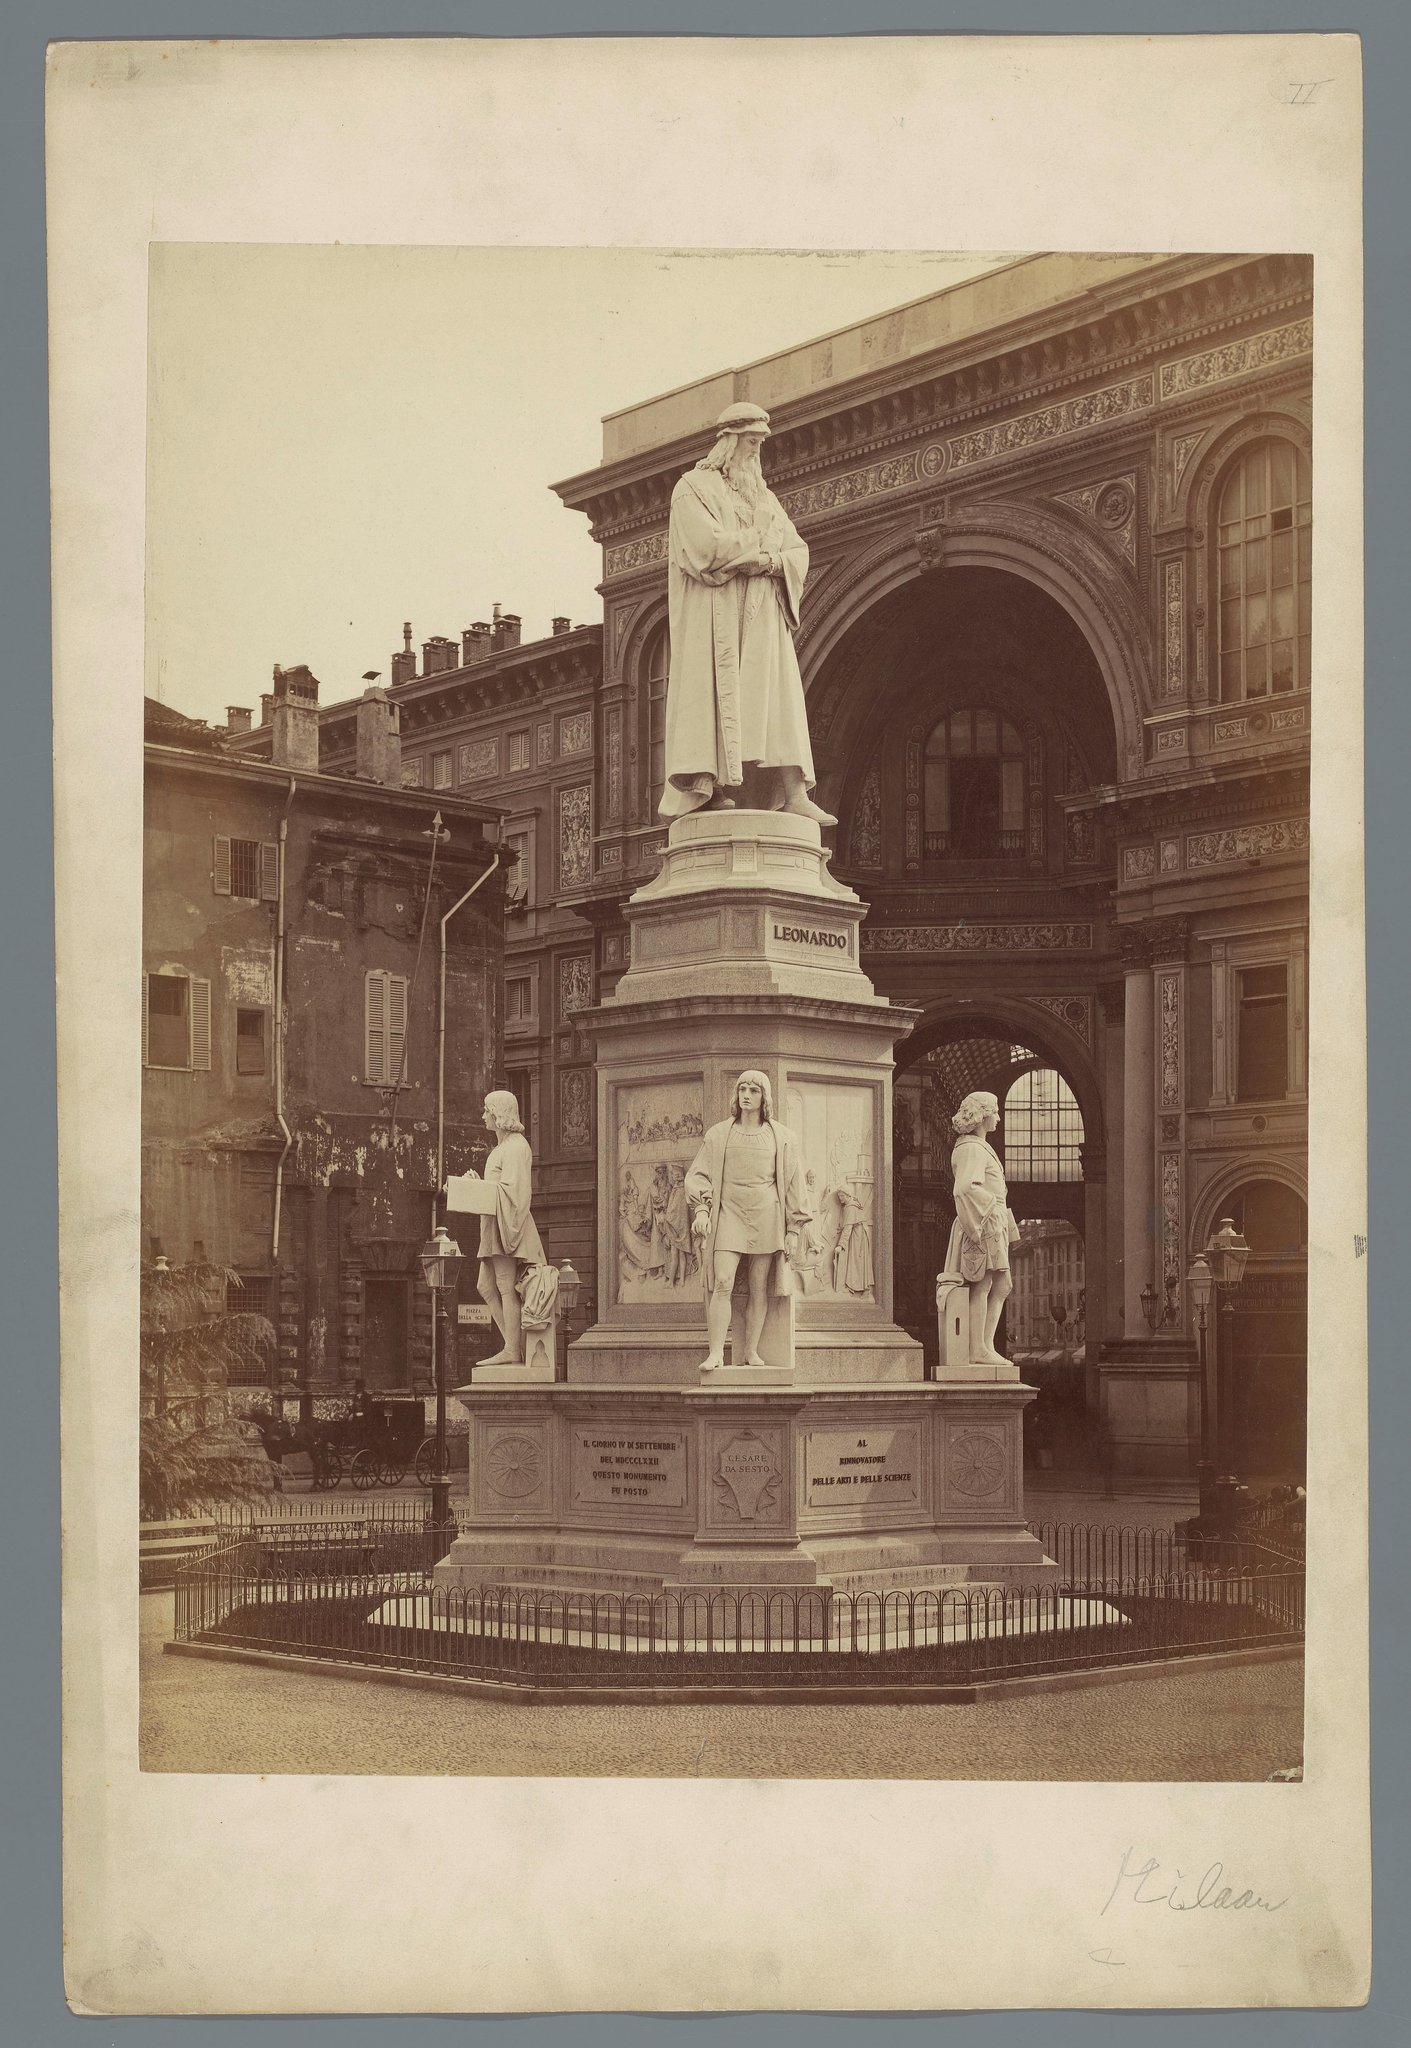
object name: photograph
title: Monument voor Leonardo da Vinci in Milaan, Italië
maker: Anonymous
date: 1873-1900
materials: cardboard, paper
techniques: albumen print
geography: milan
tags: artist, leonardo da vinci, monument, statue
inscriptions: inscription: ‘II’, inscription: ‘RSKN 1’, collector's mark: ‘RIJKS SCHOOL VOOR KUNSTNIJVERHEID/ GROEP’